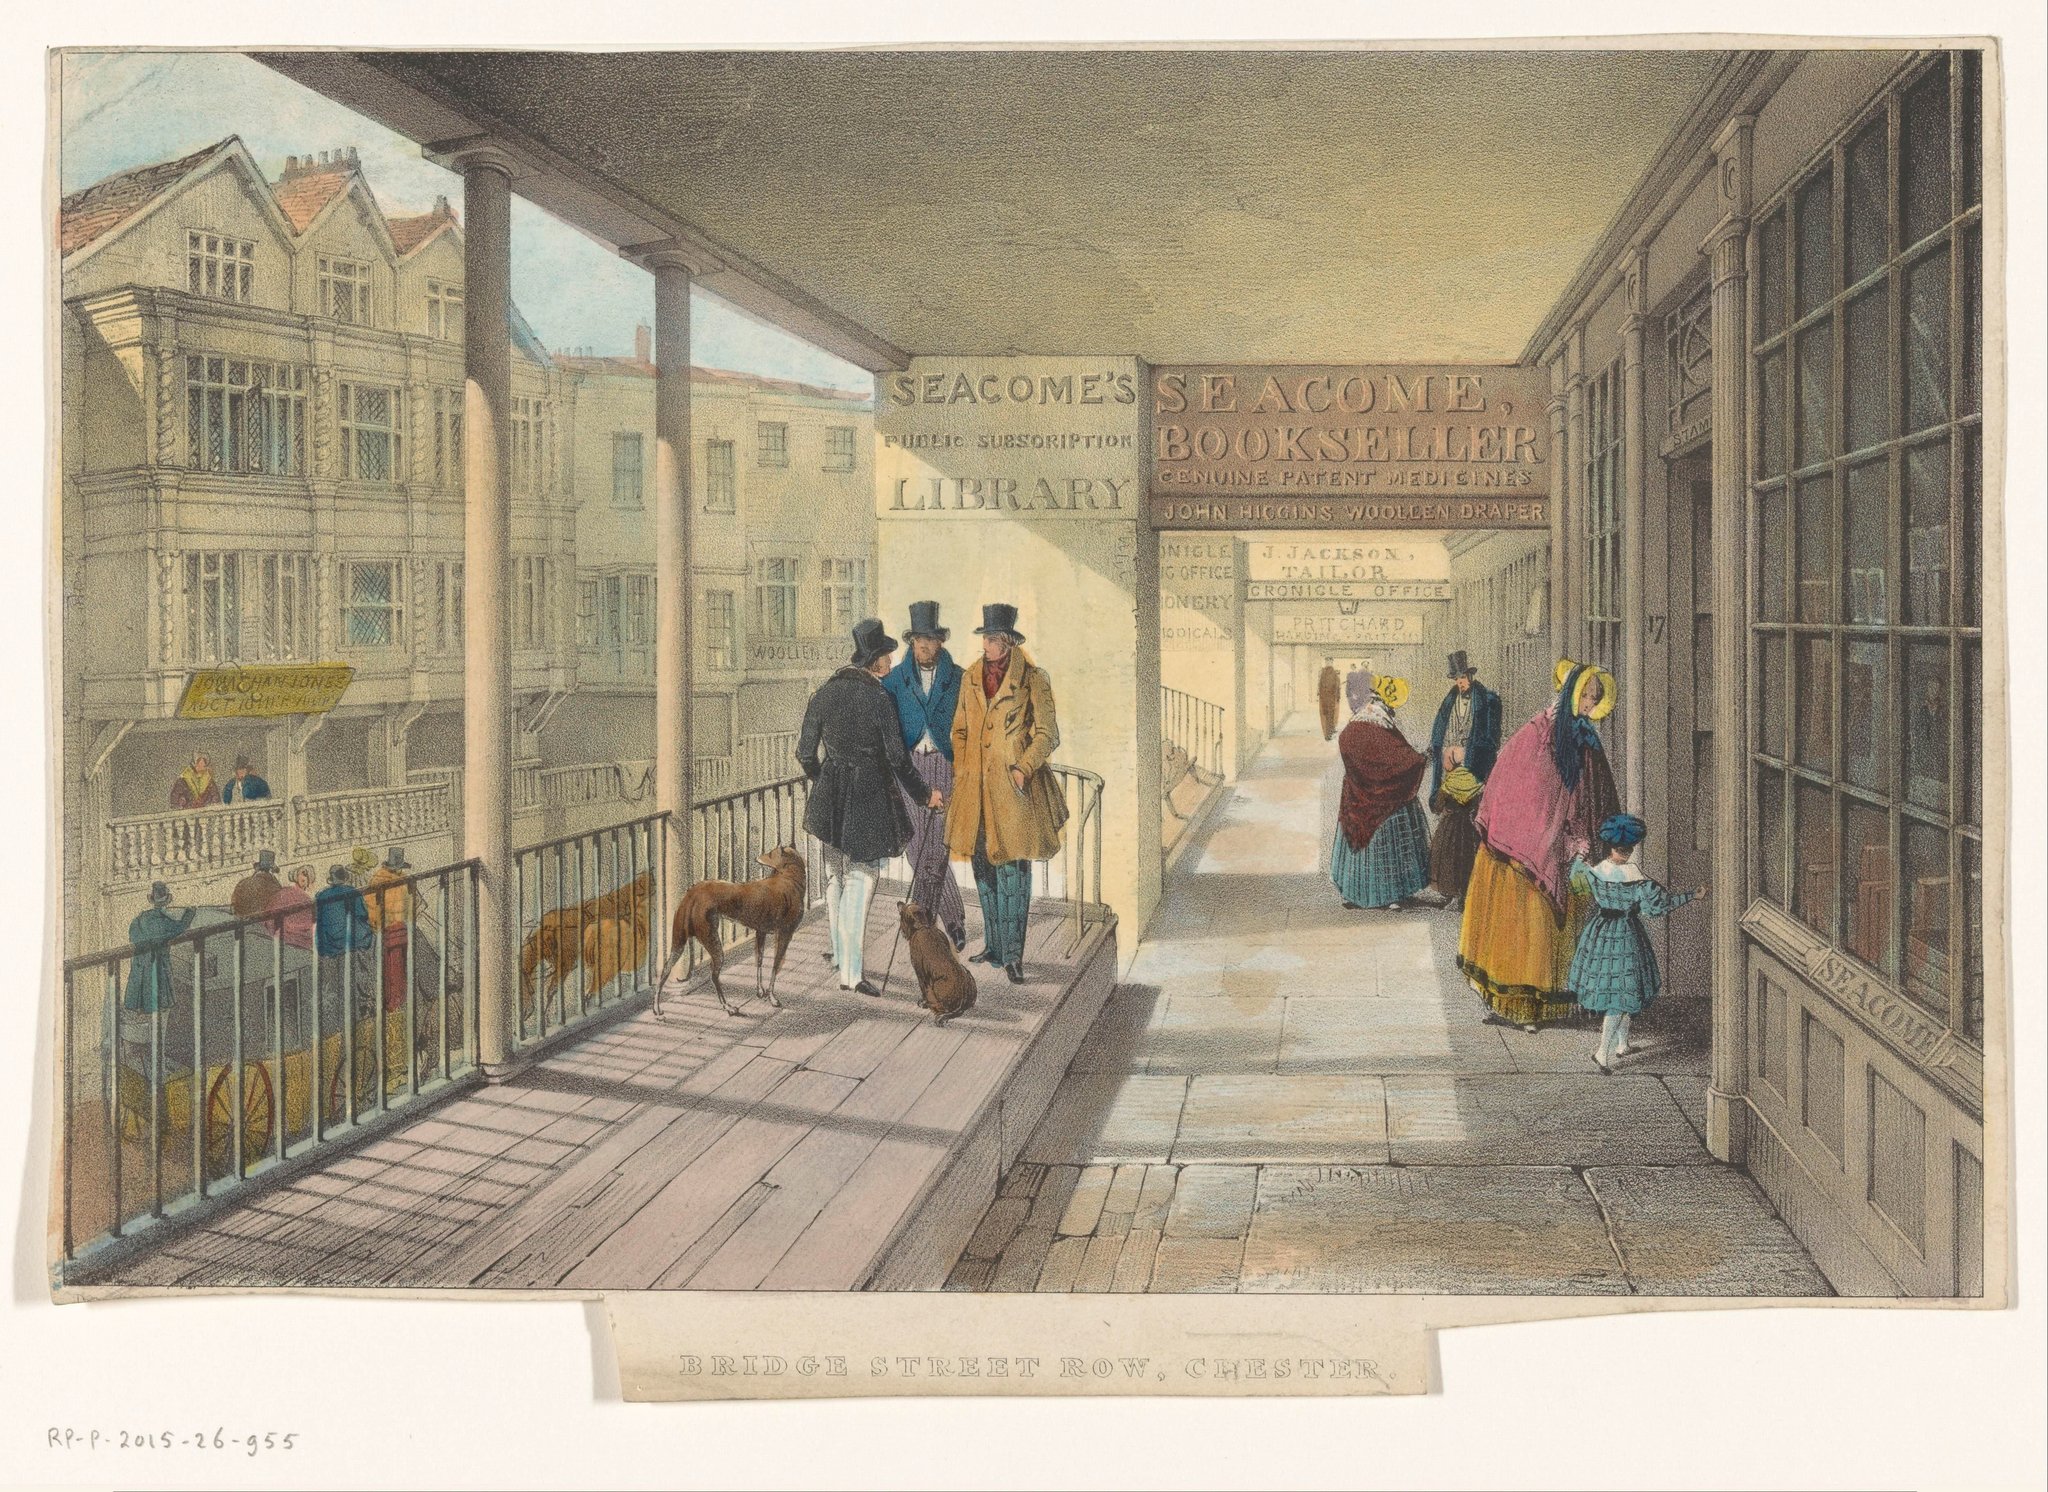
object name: print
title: Bridge Street Row, Chester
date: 1839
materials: paper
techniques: hand coloring, lithograph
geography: chester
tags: animal traction, animal-drawn vehicle (carriage etc.), shop-window, show-window, book-shop, bookseller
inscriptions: collector's mark: Lugt 4780, collector's mark: Lugt 2228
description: Gezicht op een overdekte galerij met in de voorgrond de etalage van boekhandelaar John Seacome. Op straat rijdt een paardenkoets.